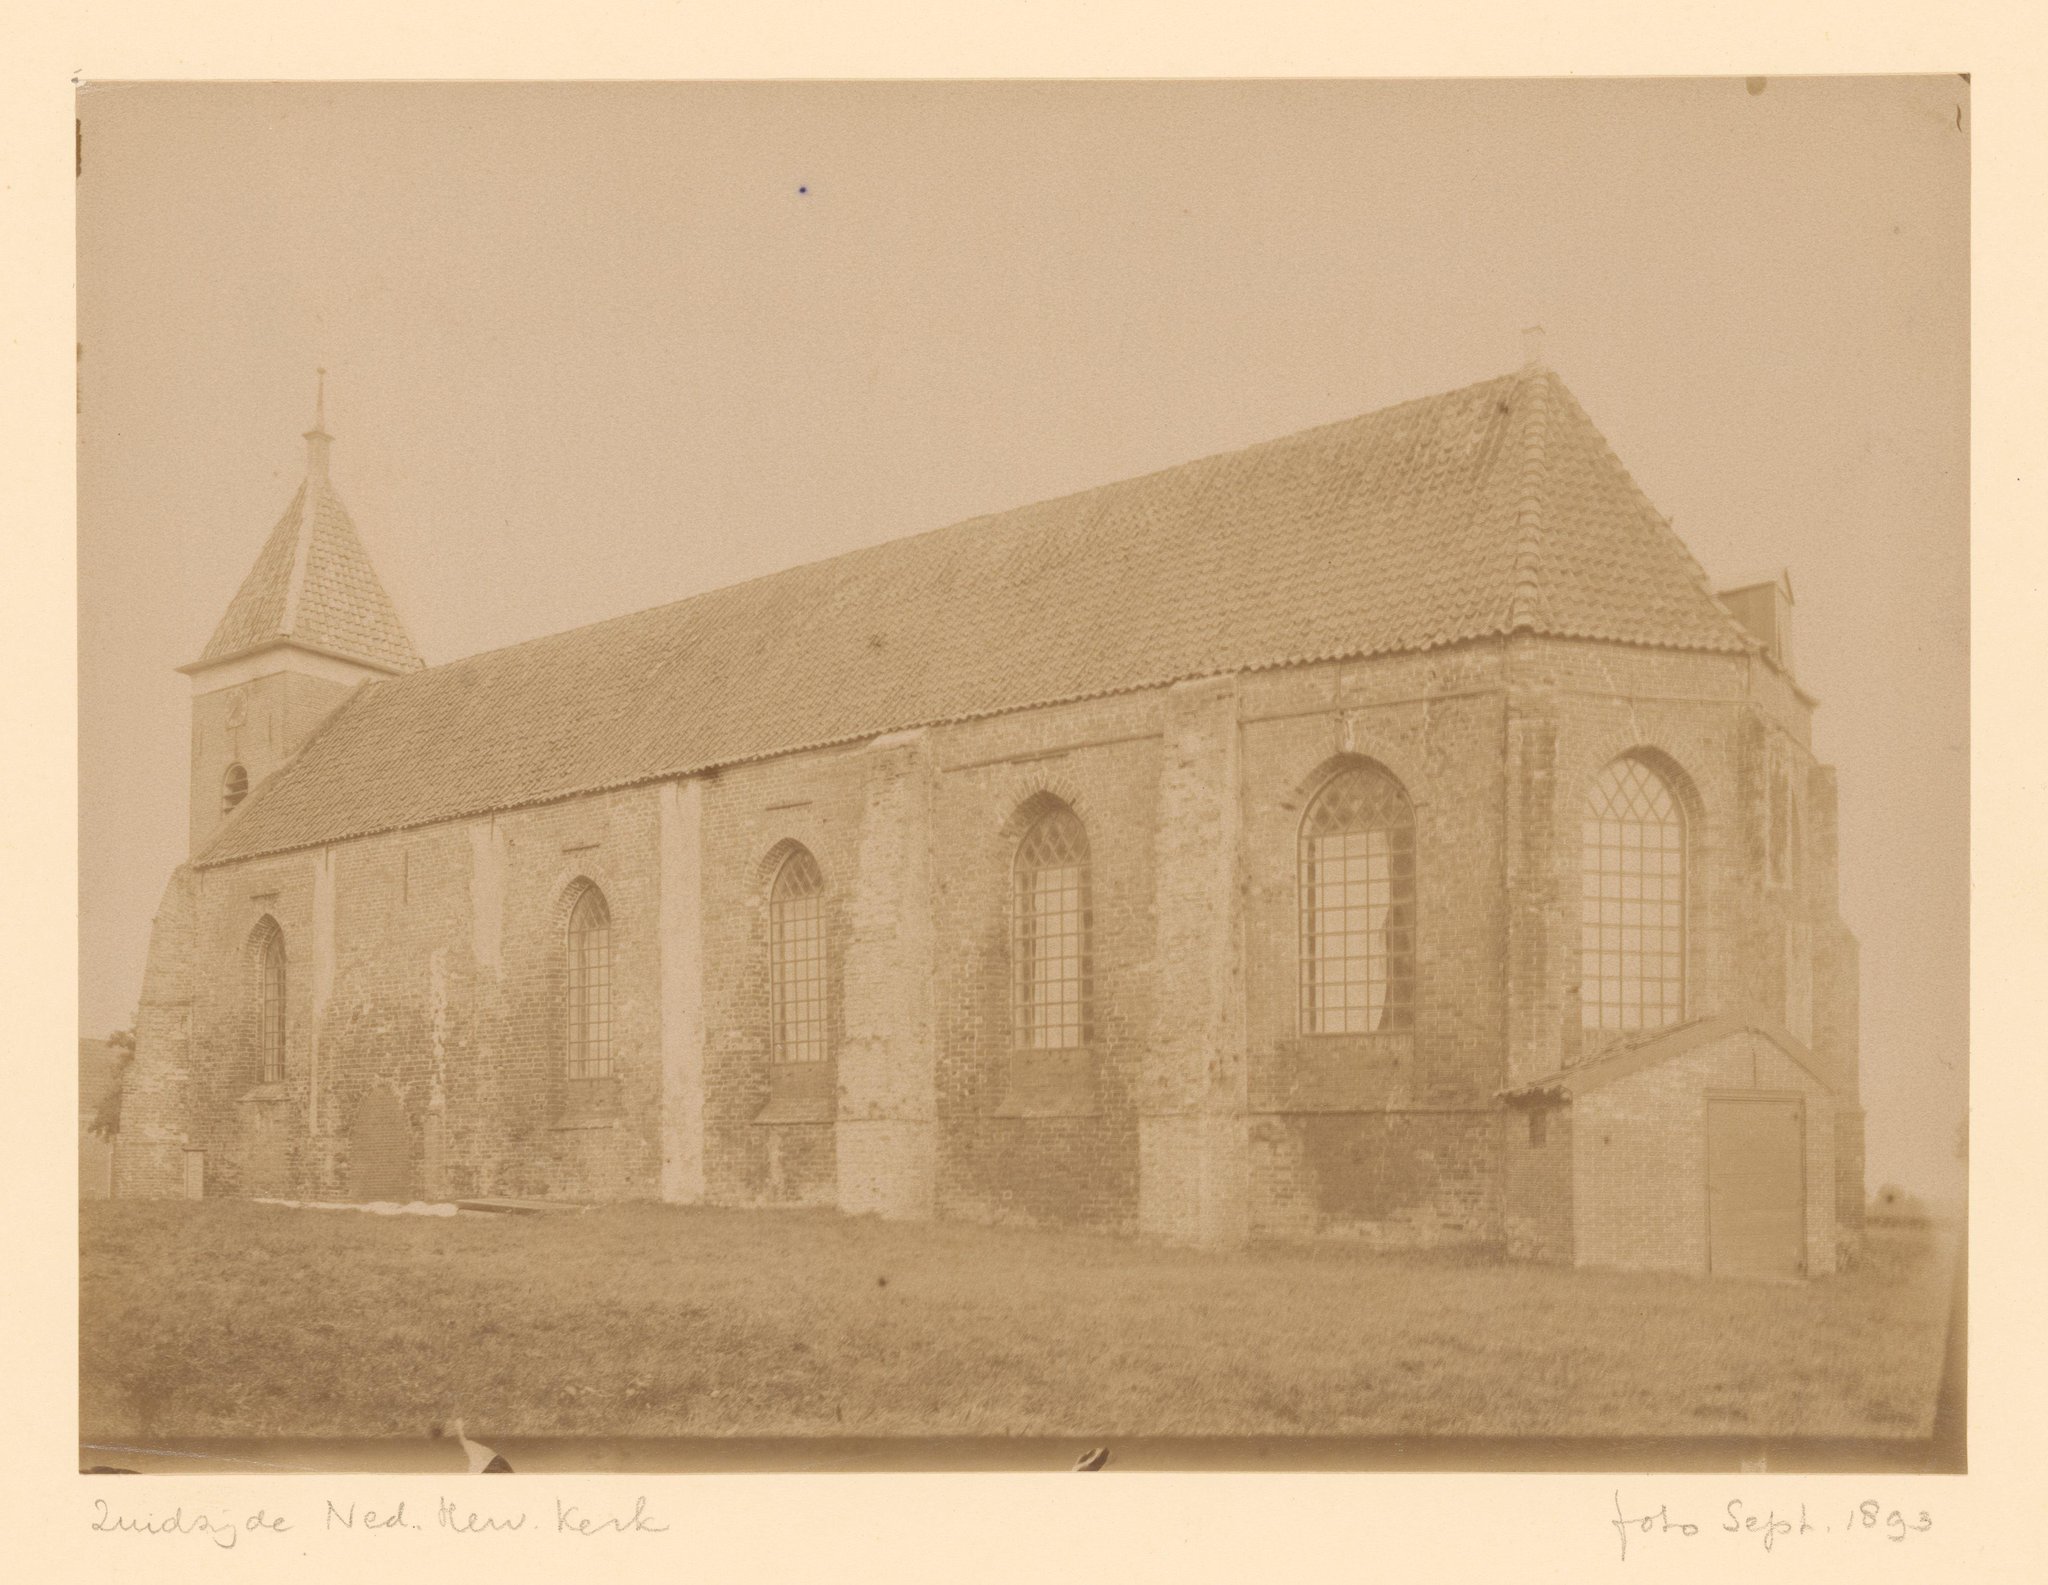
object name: photograph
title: Zuidzijde van de Kerk van Vlagtwedde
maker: anoniem (monumentenzorg)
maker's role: fotograaf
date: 1893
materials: cardboard, photographic support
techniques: albumen print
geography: vlagtwedde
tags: church (exterior)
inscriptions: annotation: ‘Zuidzijde/ Ned. Herv. Kerk/ foto sept. 1893/ Vlagtwedde’, annotation: ‘Vlagtwedde/ Zuidzijde N.H. kerk/ sept 1893’